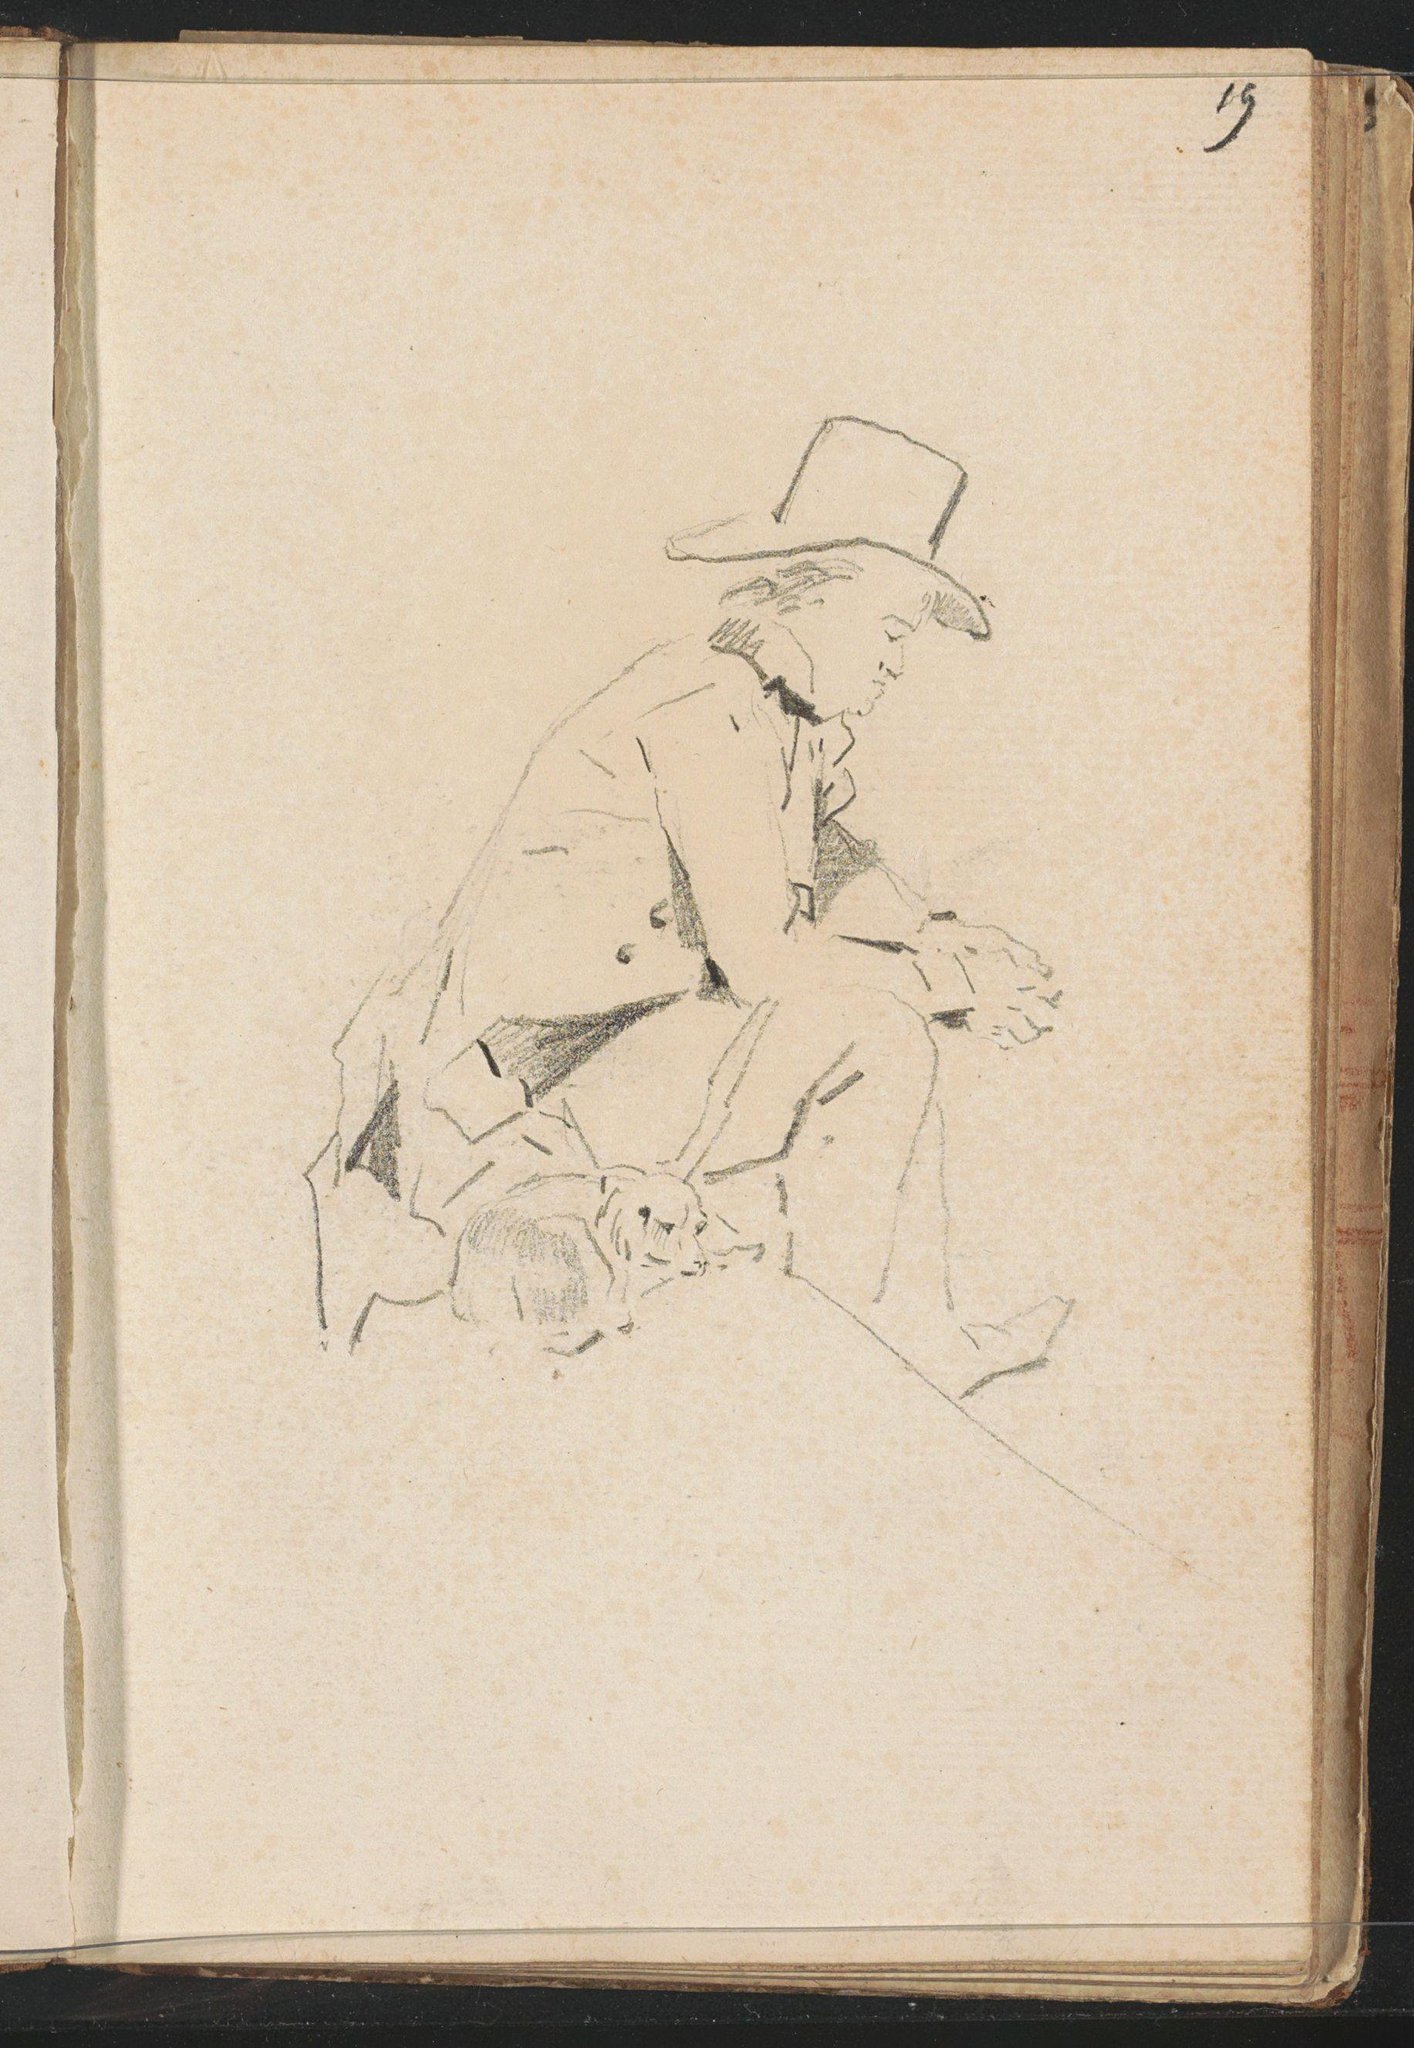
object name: sketchbook leaf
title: Man zittend op een bank naast een hond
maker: jacob perkois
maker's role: draughtsman, print maker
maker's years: 1756-1804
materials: paper, pencil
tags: sitting figure, dog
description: De man draagt een hoge hoed en een overjas met knopen. Hij heeft de handen ineengevouwen. Bladzijde 19 uit een schetsboek met 78 bladzijden.